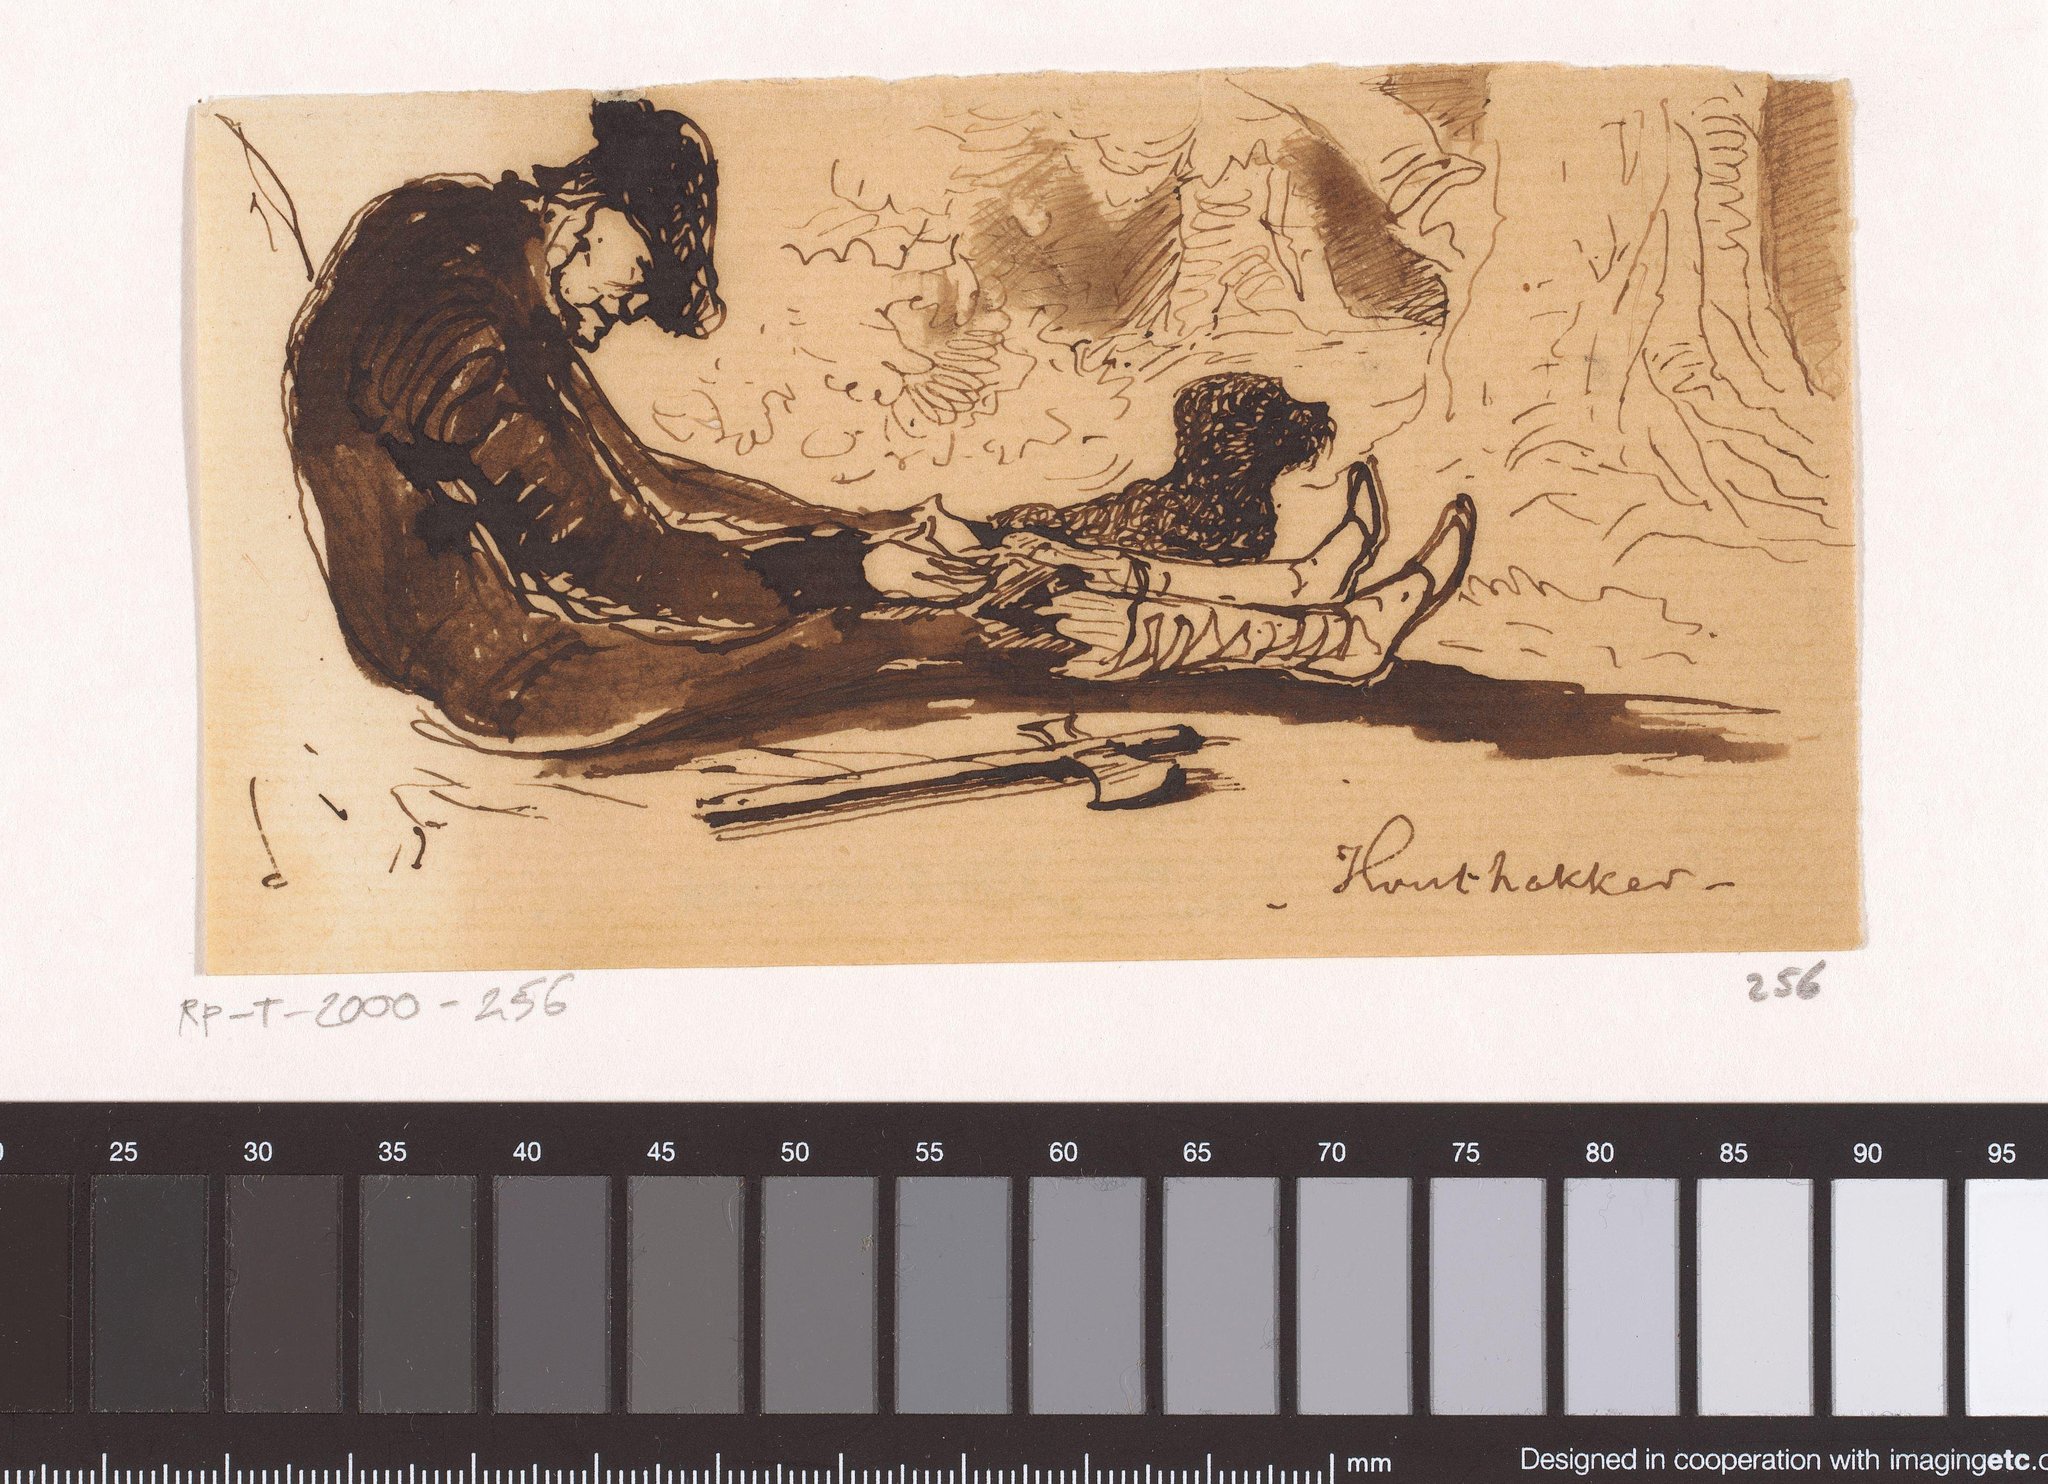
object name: drawing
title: Houthakker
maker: johannes tavenraat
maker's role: draughtsman, painter, print maker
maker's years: 1809-1881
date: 1840-1880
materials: ink, paper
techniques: brush, pen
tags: forest worker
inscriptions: annotation: ‘Houthakker’, collector's mark: Lugt 2228